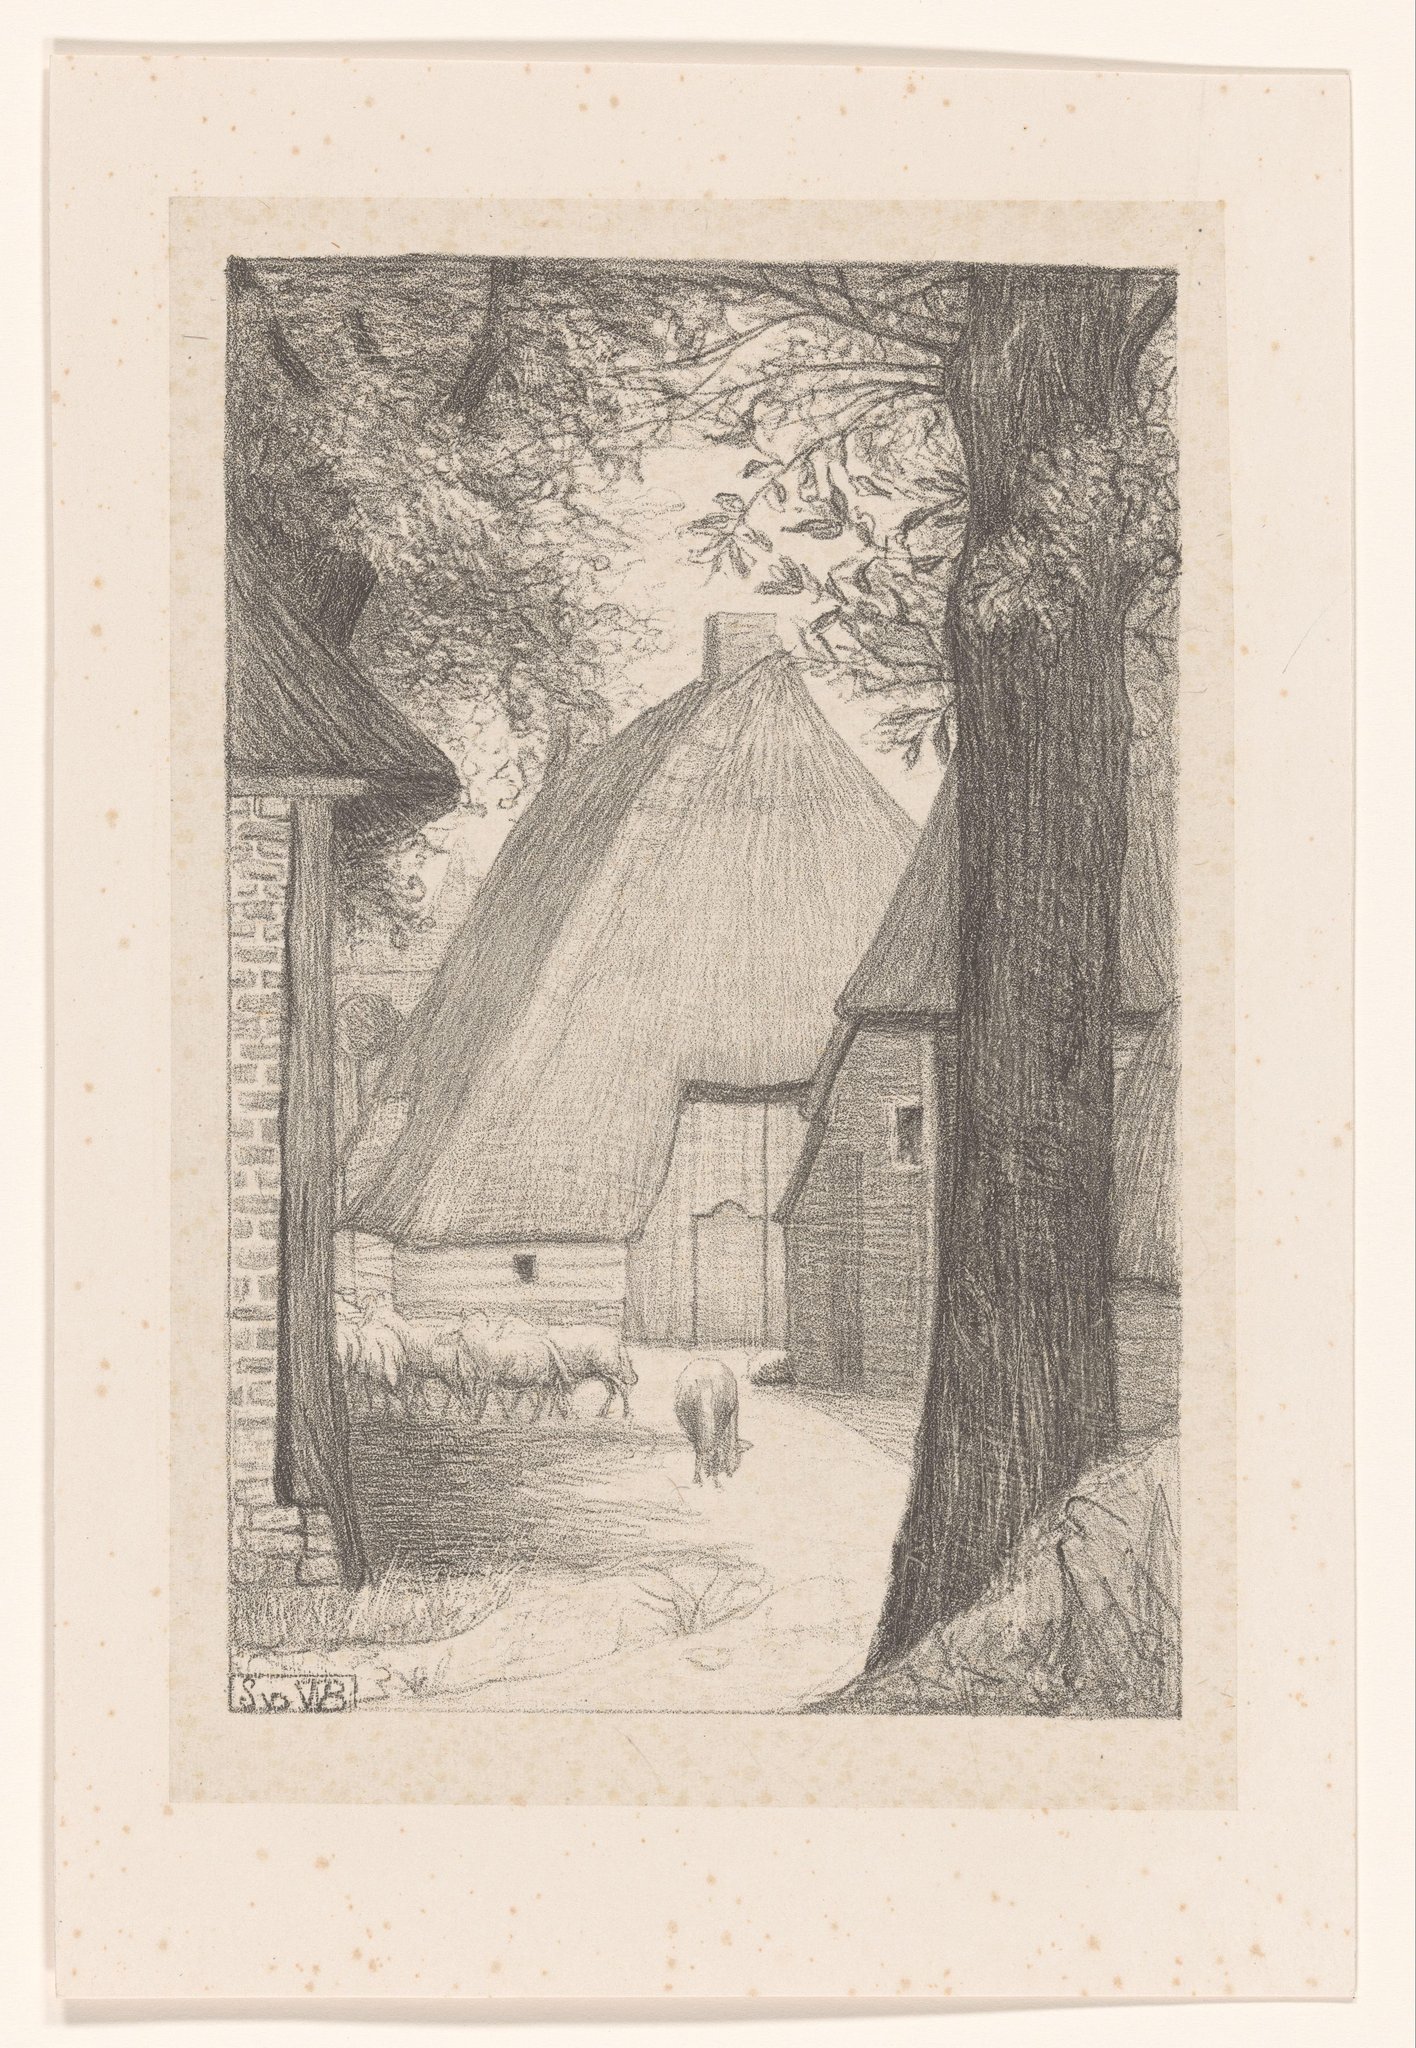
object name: print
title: Schuren met schapen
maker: sophie christina van den wall bake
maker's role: print maker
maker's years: 1866-1915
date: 1876-1915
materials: paper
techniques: lithograph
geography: netherlands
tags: barn, trees, sheep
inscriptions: collector's mark: Lugt 2760, collector's mark: Lugt 2228